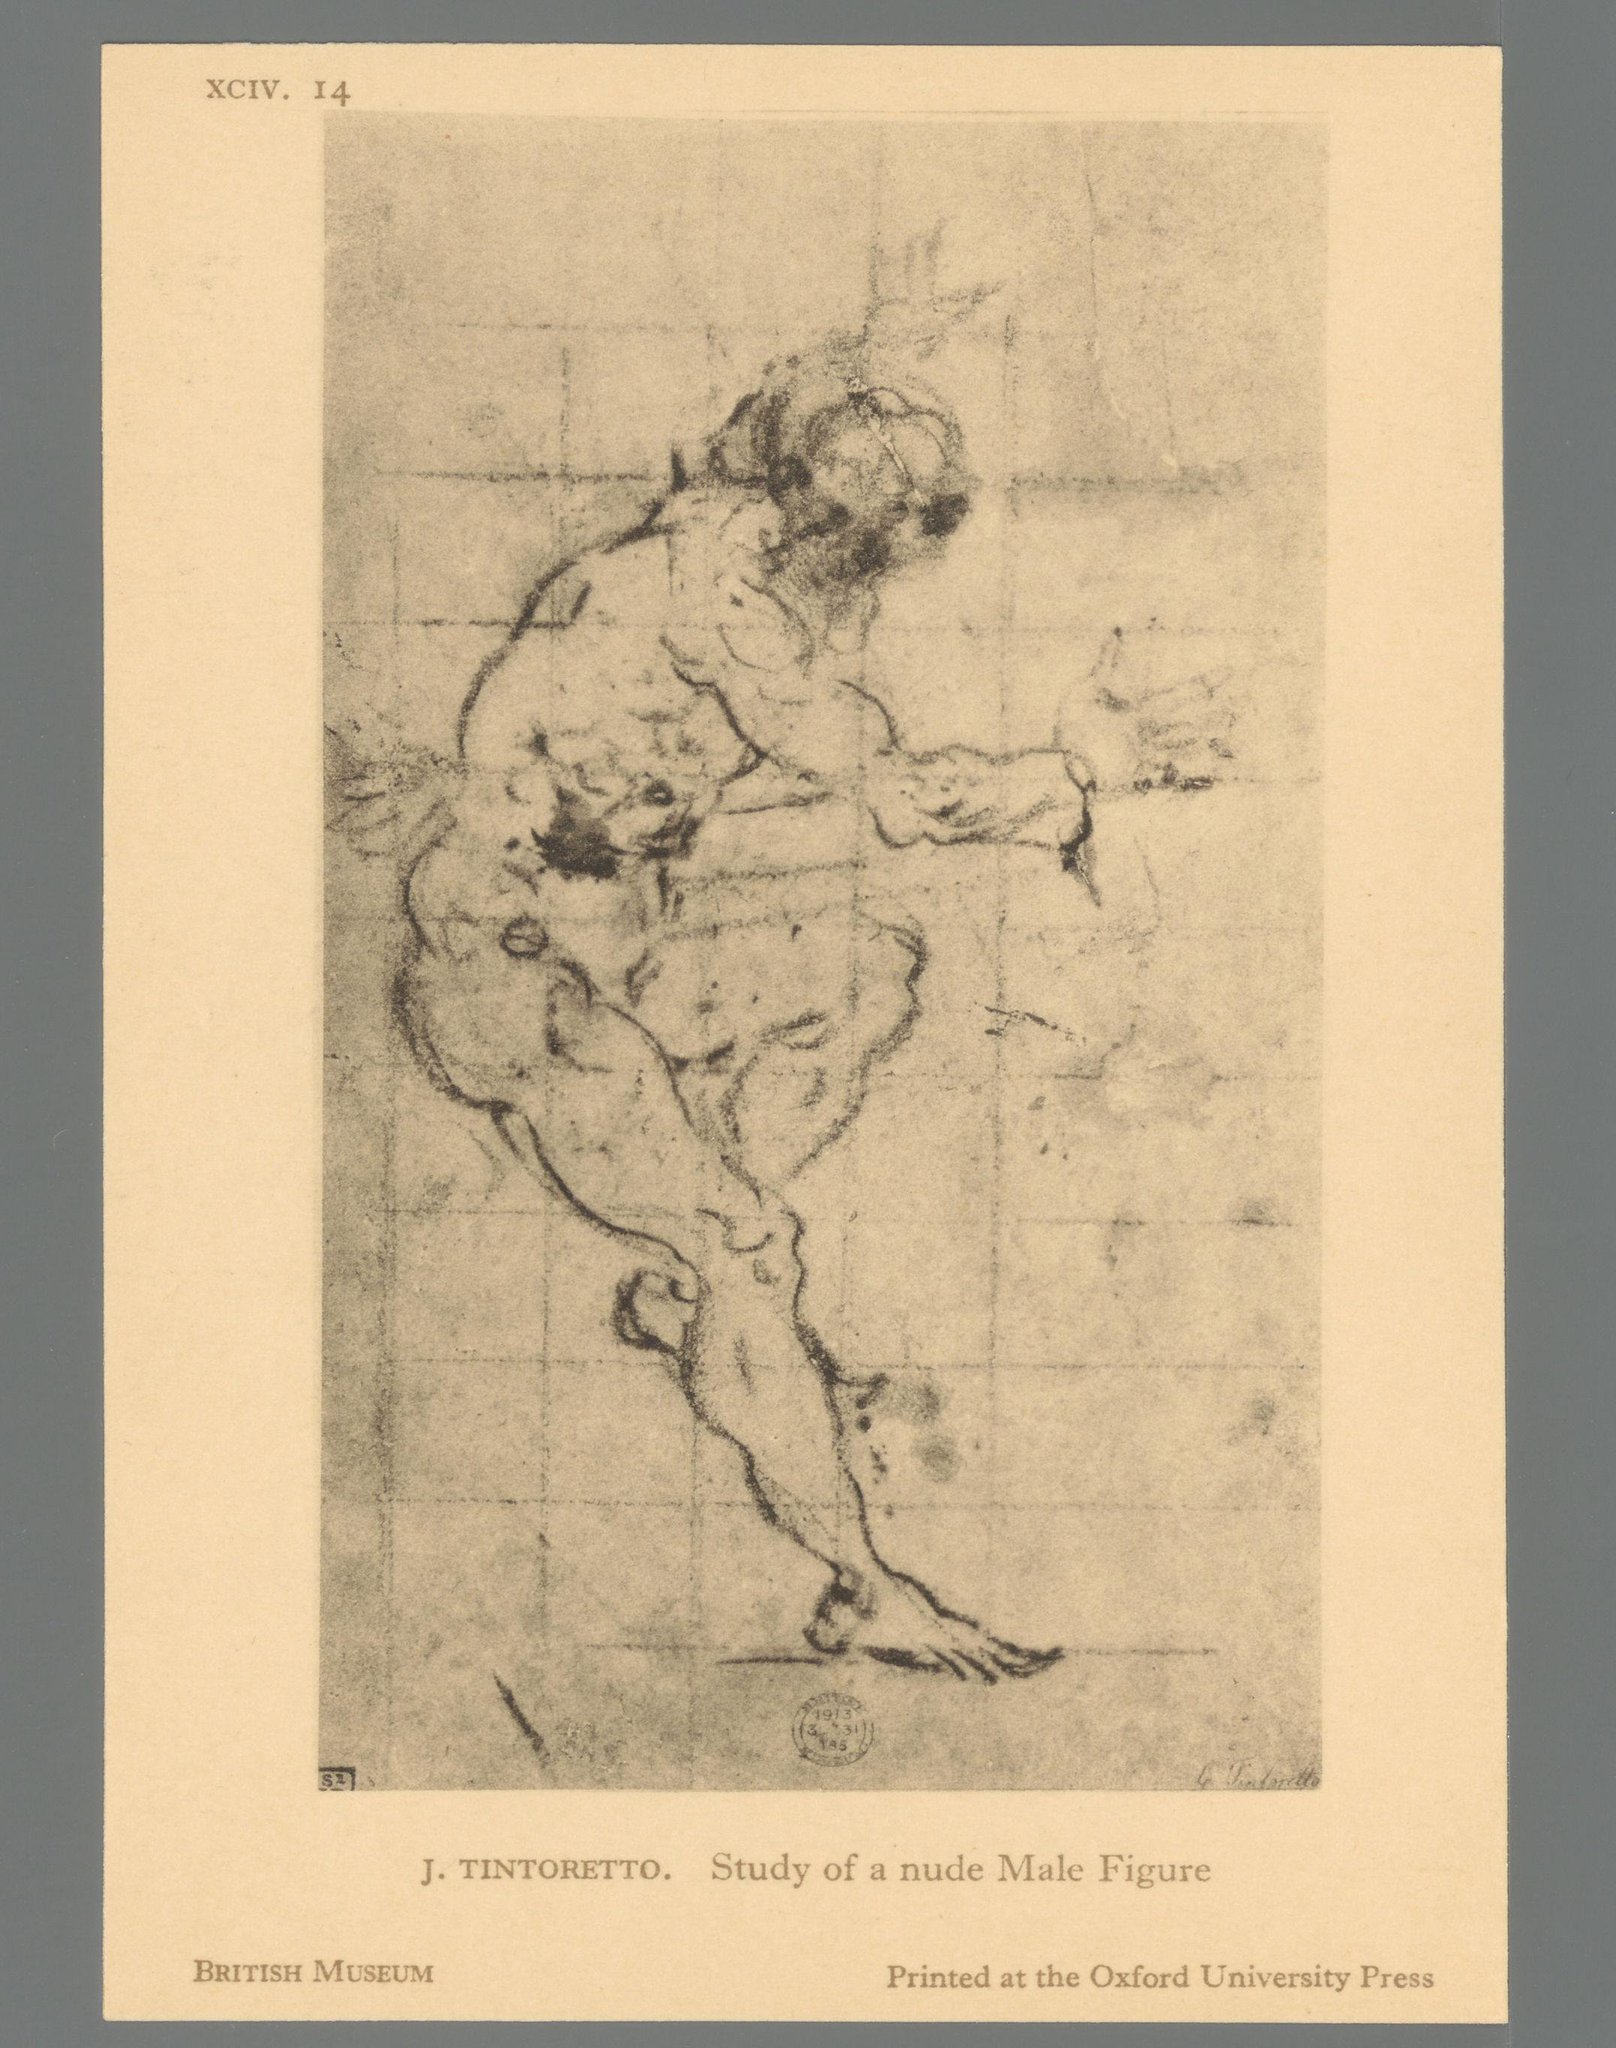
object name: photomechanical print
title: J. Tintoretto. Study of a nude Male Figure. British Museum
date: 1902-1950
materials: cardboard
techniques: photograph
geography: oxford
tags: drawing, sketch, permanent exhibition, museum